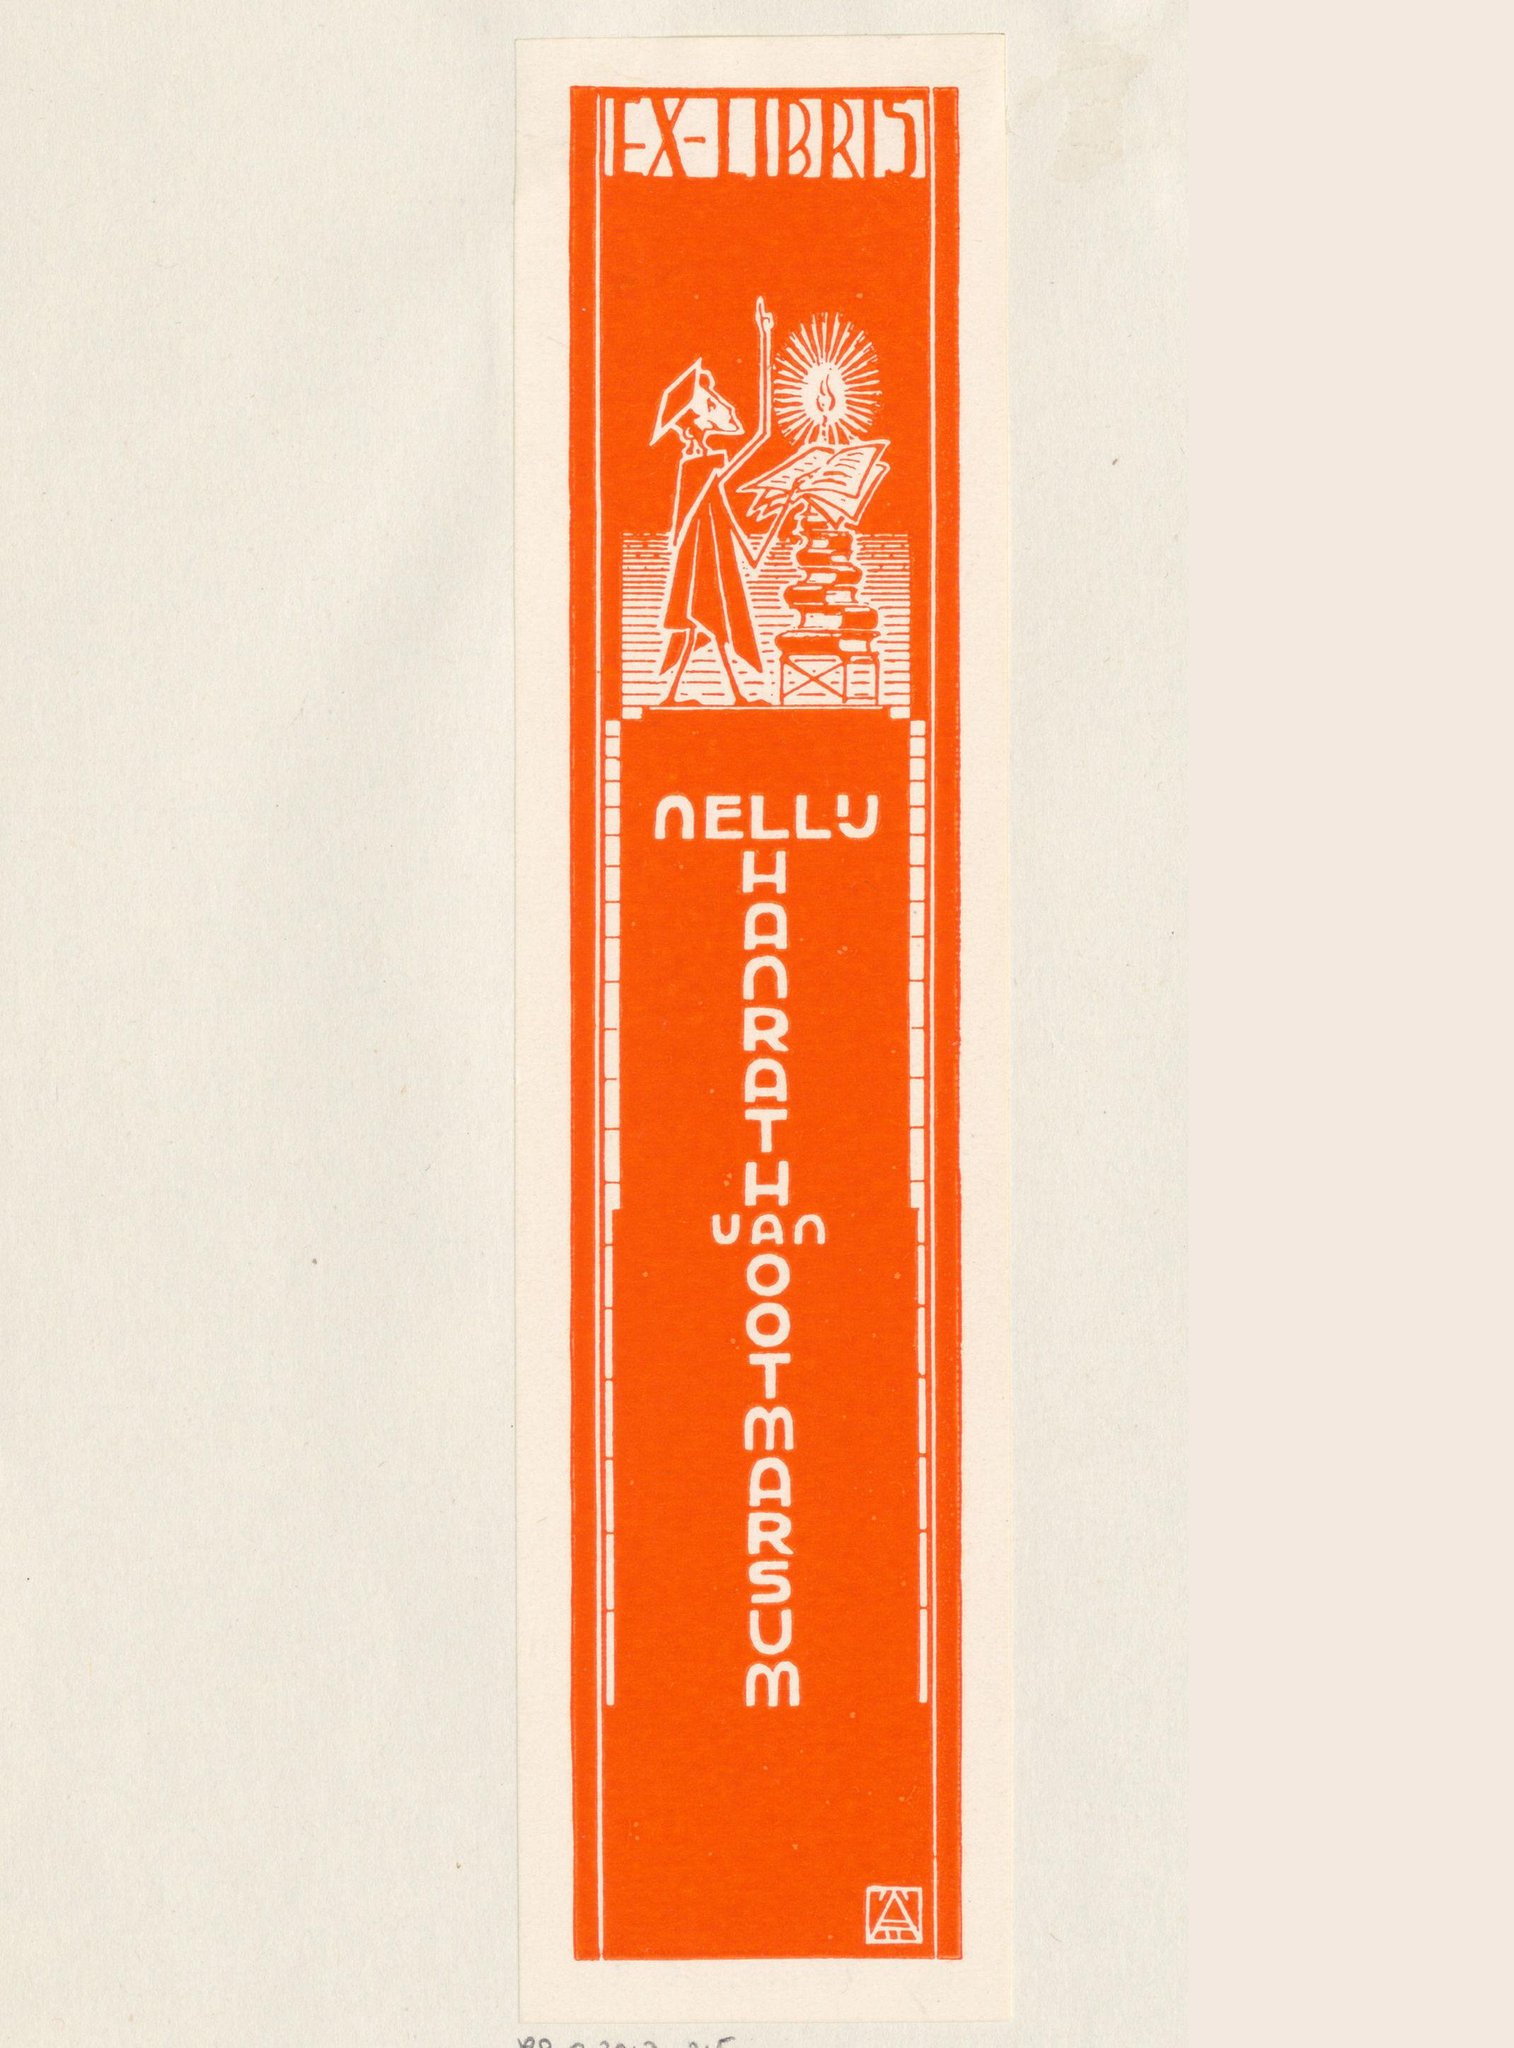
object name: bookplate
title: Ex libris van Nelly Hanrath-van Ootmarsum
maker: constant joseph alban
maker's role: painter, print maker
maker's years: 1873-1944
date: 1932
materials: paper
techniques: printing block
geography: netherlands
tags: scholar in his study, candle